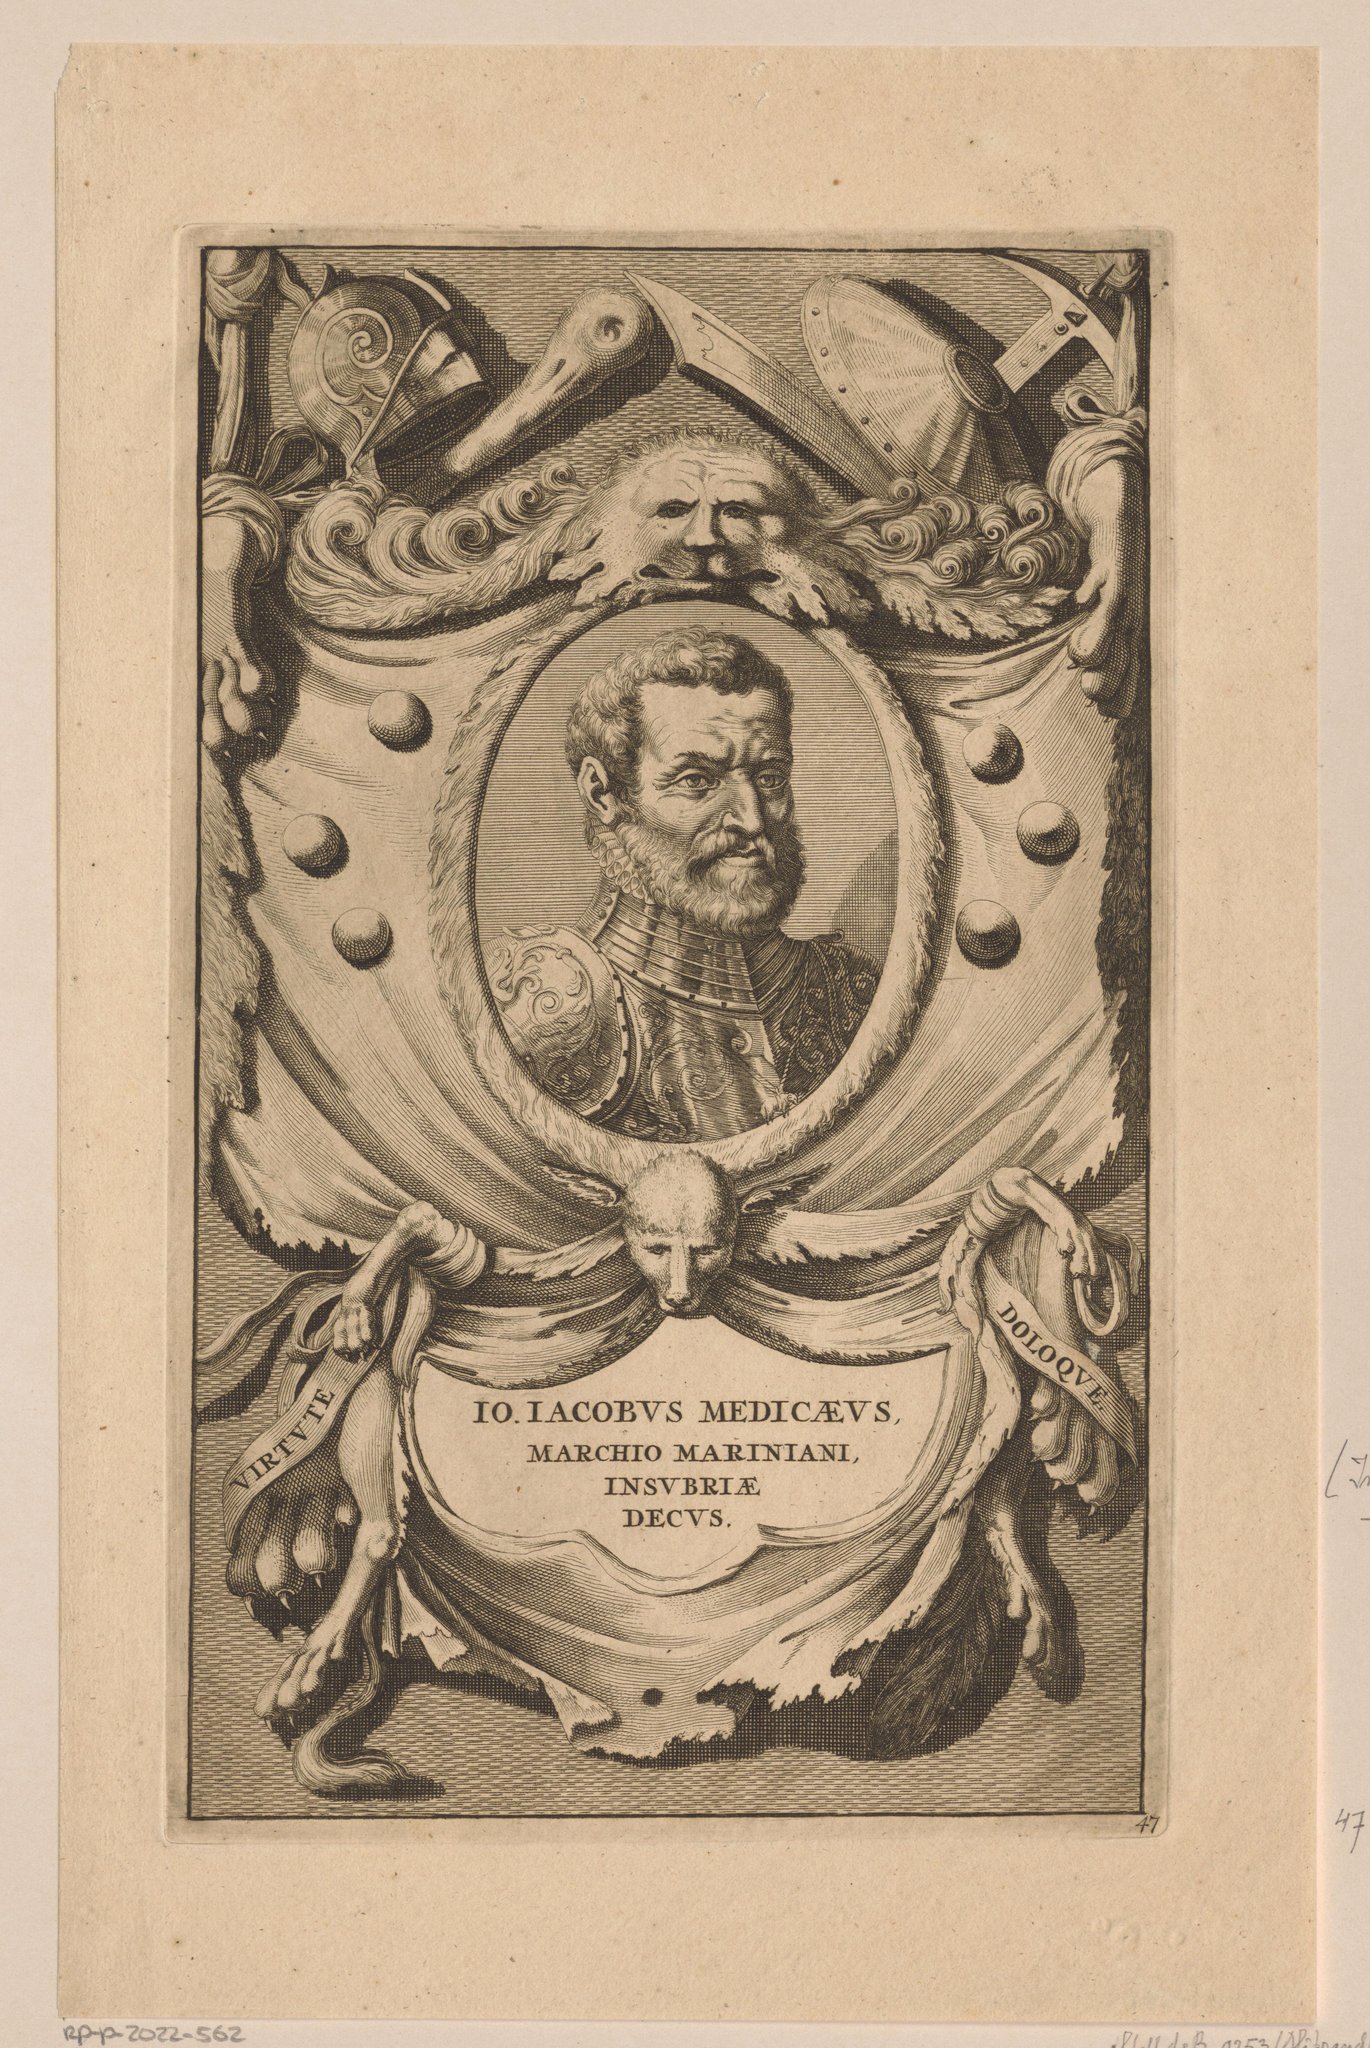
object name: print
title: Principum et illustrium quorundam virorum qui in Europa alibique terrarum quam fama quam eruditione celebres fuerunt, verae imagines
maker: Anonymous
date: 1710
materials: paper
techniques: etching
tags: historical persons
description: Prent waarschijnlijk uit de serie: Principum et illustrium quorundam virorum qui in Europa alibique terrarum quam fama quam eruditione celebres fuerunt, verae imagines. Leiden: Pieter van der Aa, [ca. 1710].